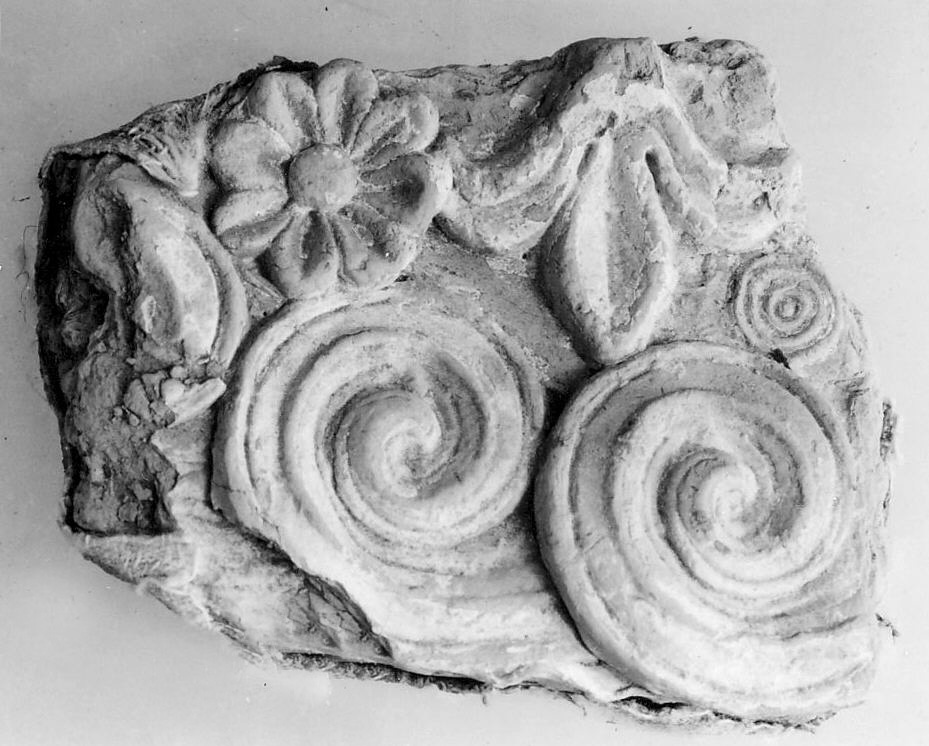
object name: relief fragment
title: Fragment of a Relief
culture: central asian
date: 201-700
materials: clay